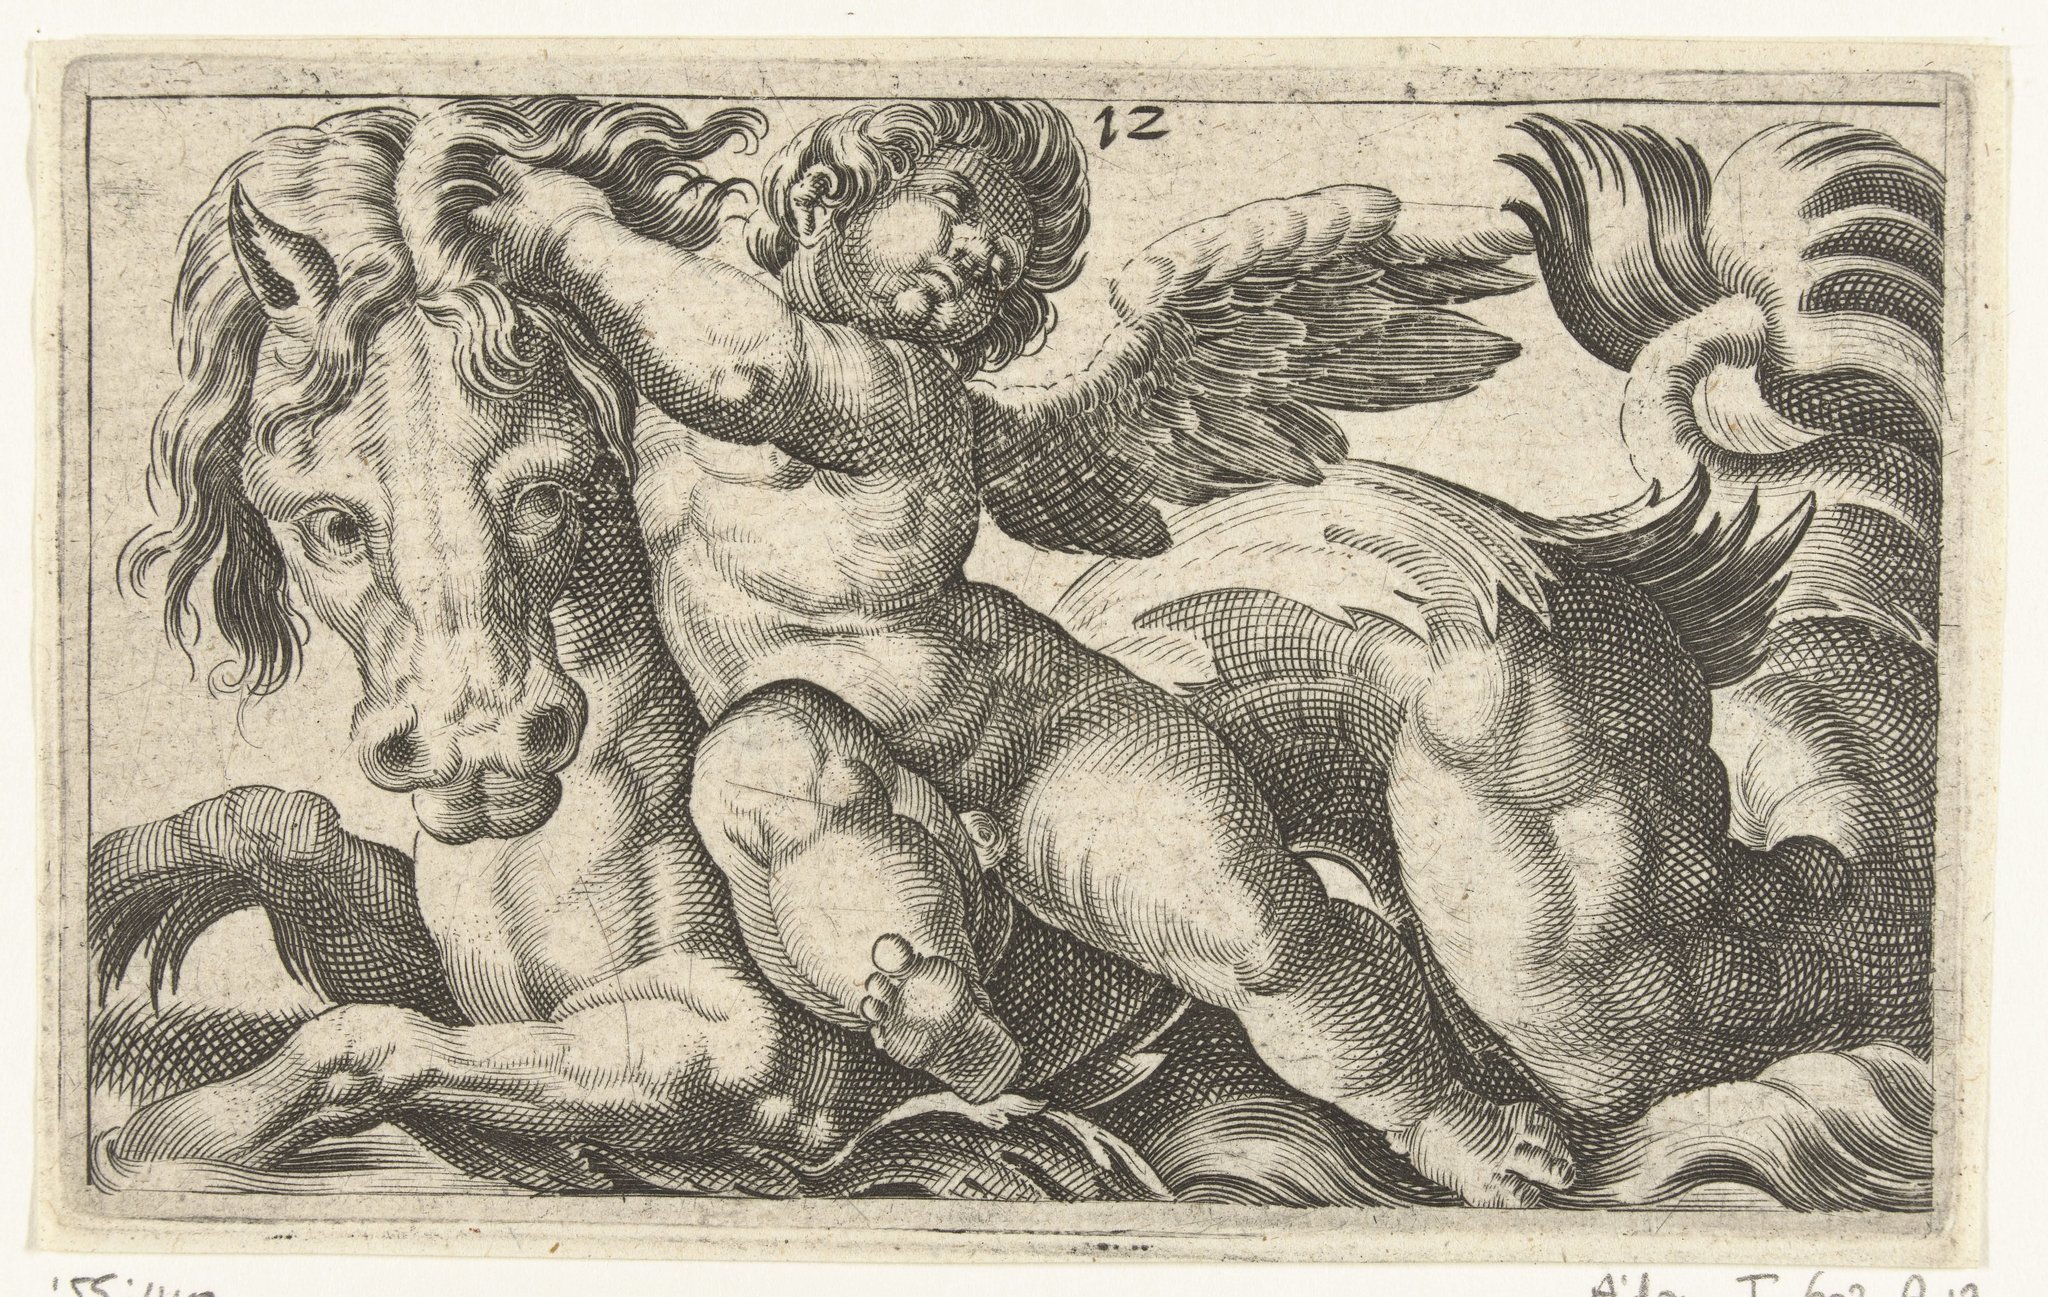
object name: ornament print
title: Putti op zeewezens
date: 1605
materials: paper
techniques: engraving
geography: germany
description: Met beide handen klampt de putto zich vast aan de manen van het paard. Tegenzijdige kopie naar een prent van Giovanni Andrea Maglioli.